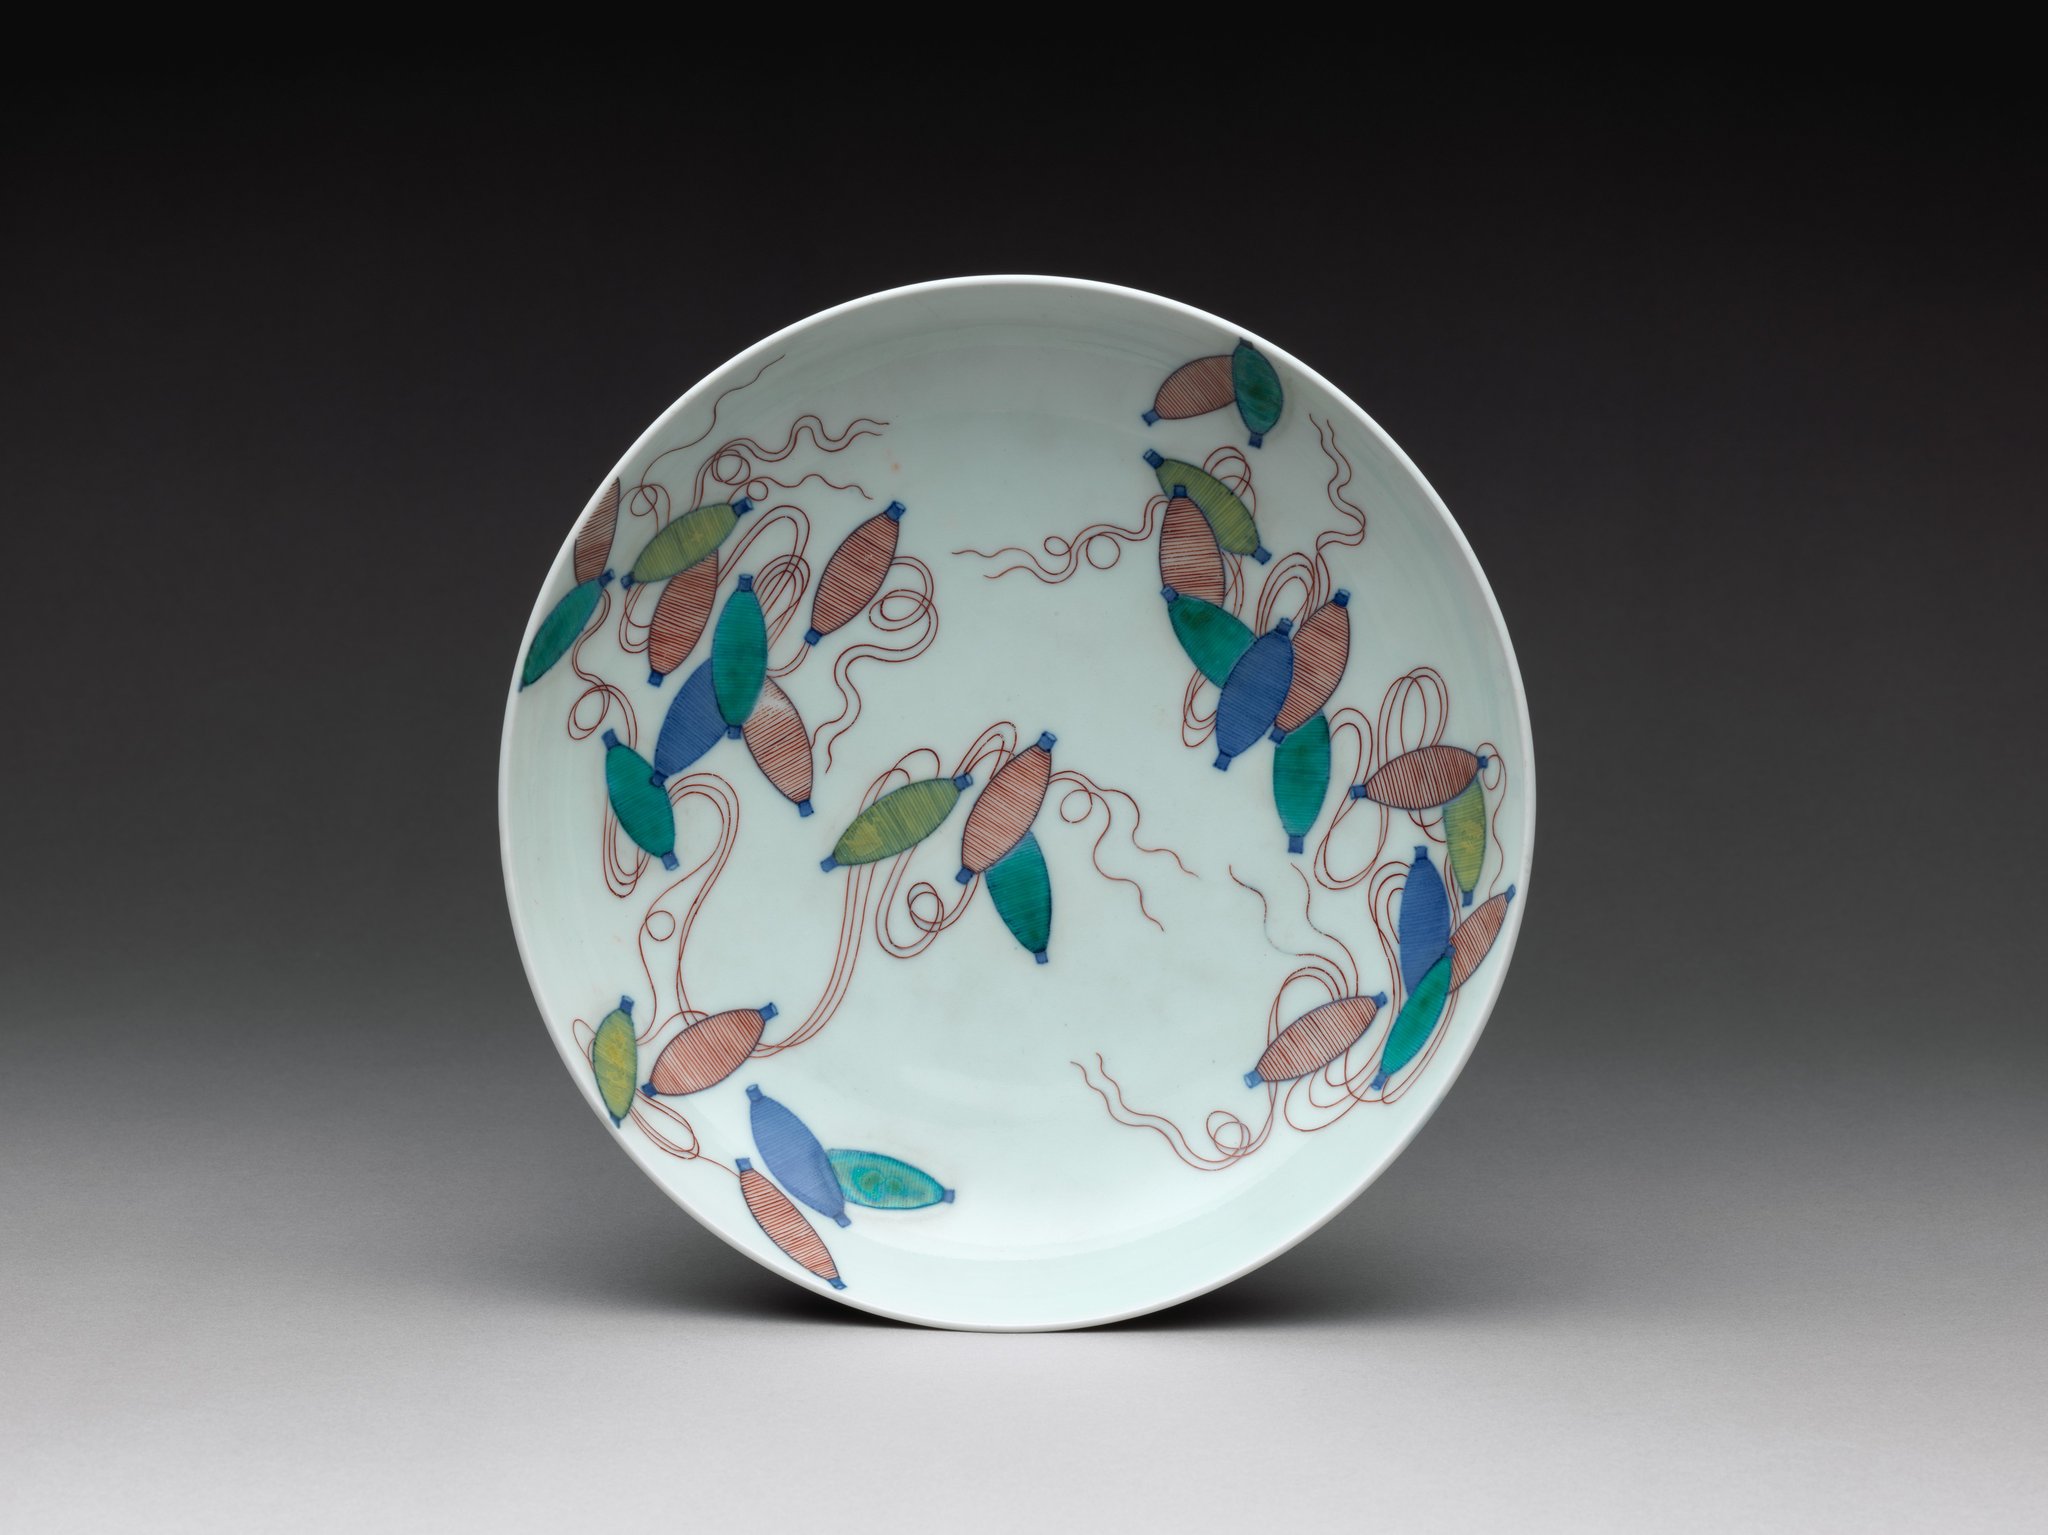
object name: dish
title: Dish with Design of Spools of Thread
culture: japanese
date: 1701-1733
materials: enamel, porcelain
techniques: overglaze, underglaze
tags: flowers